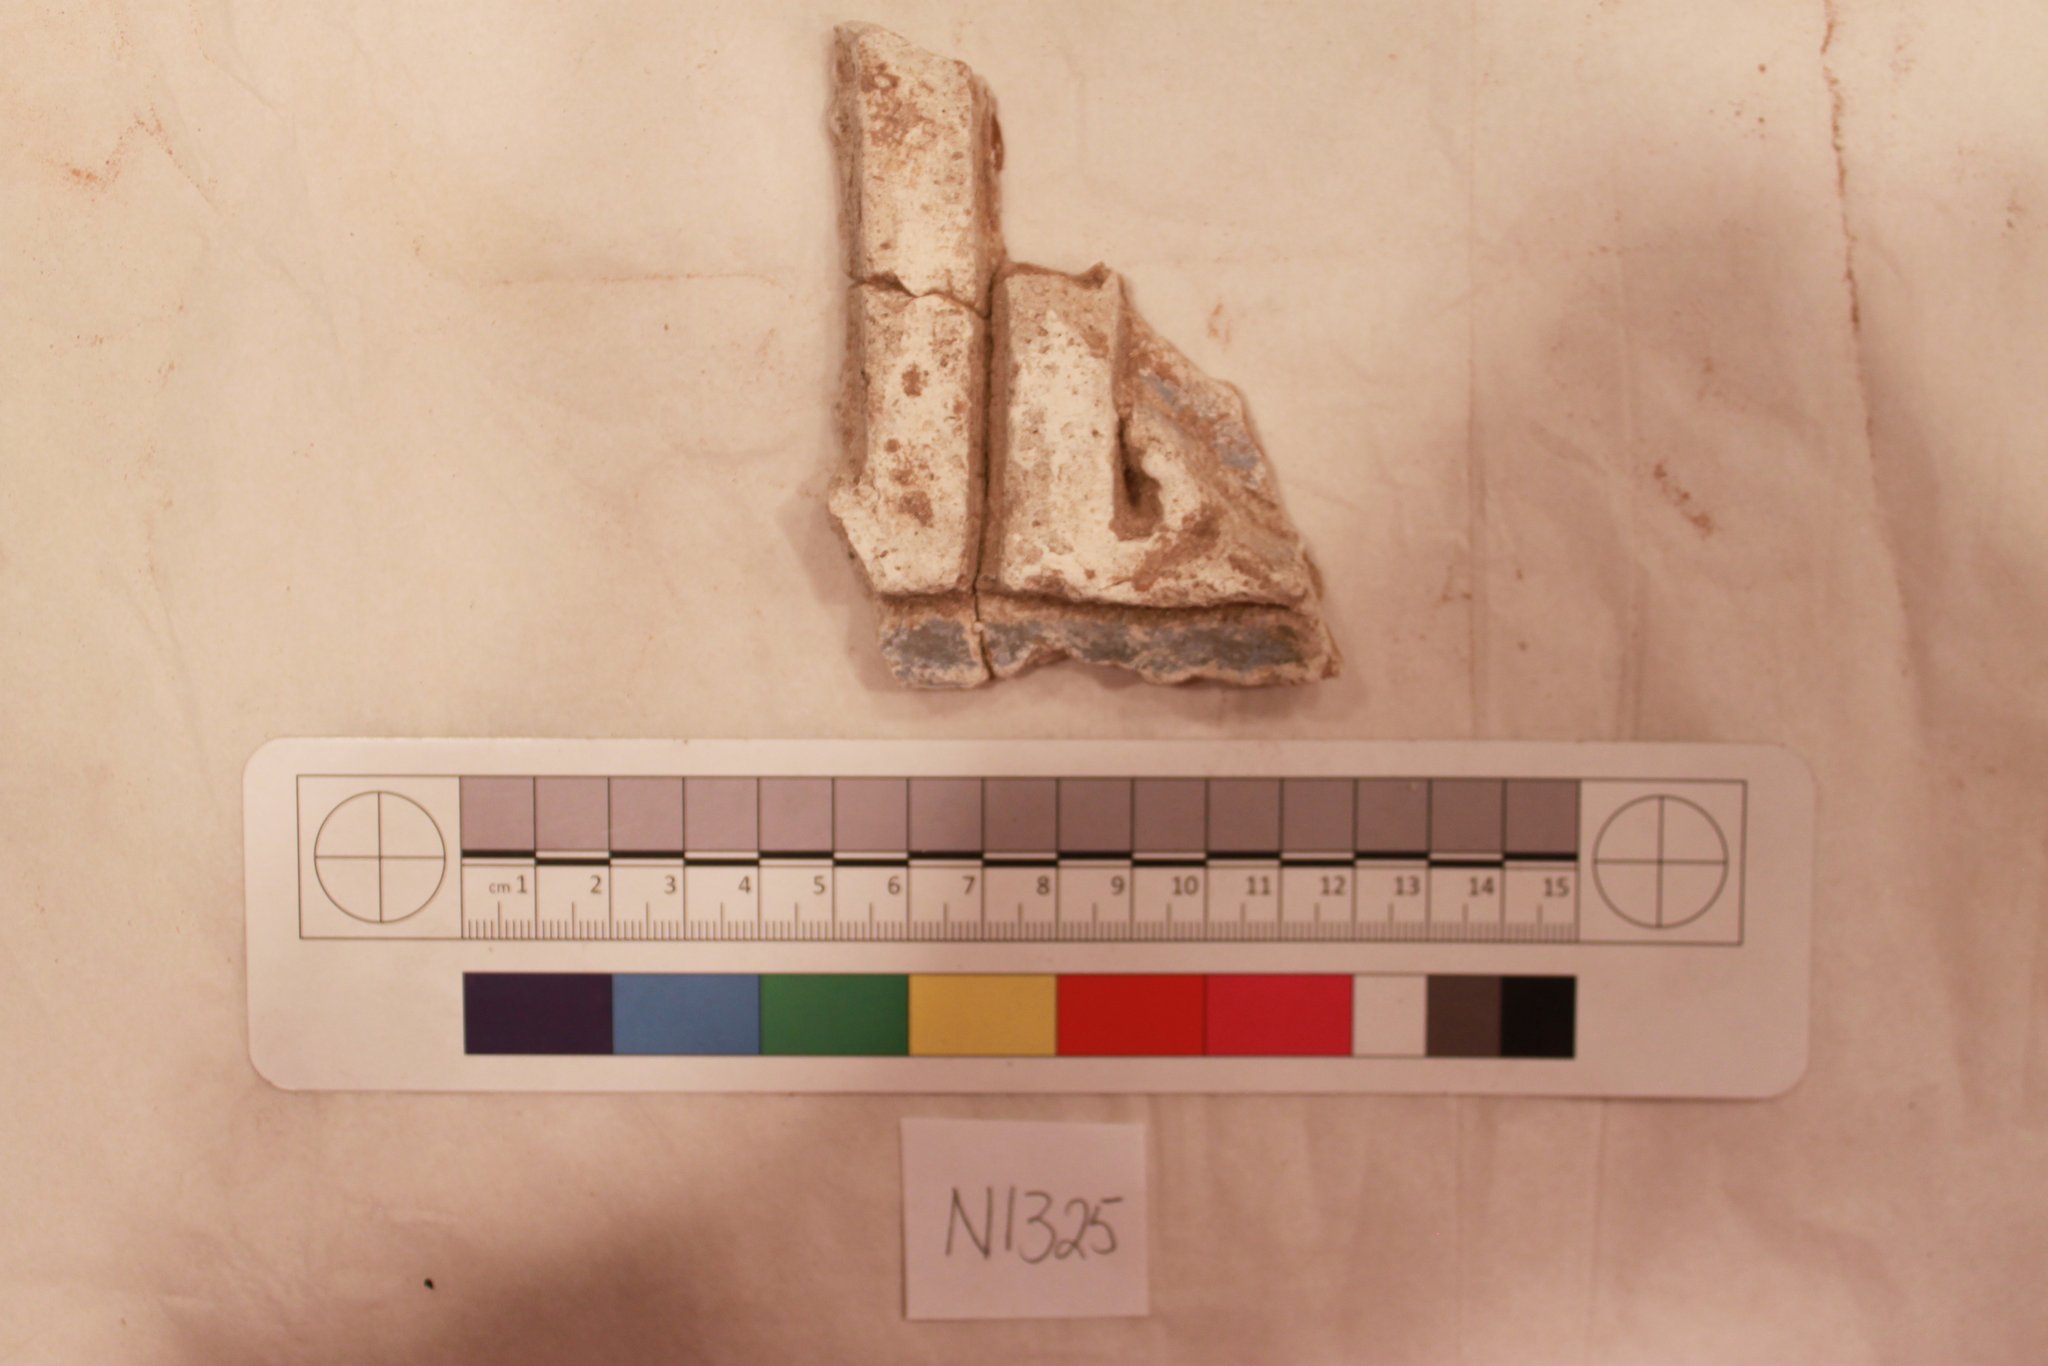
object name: fragment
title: Stucco Fragment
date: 701-1200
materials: plaster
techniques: carving, painting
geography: iran